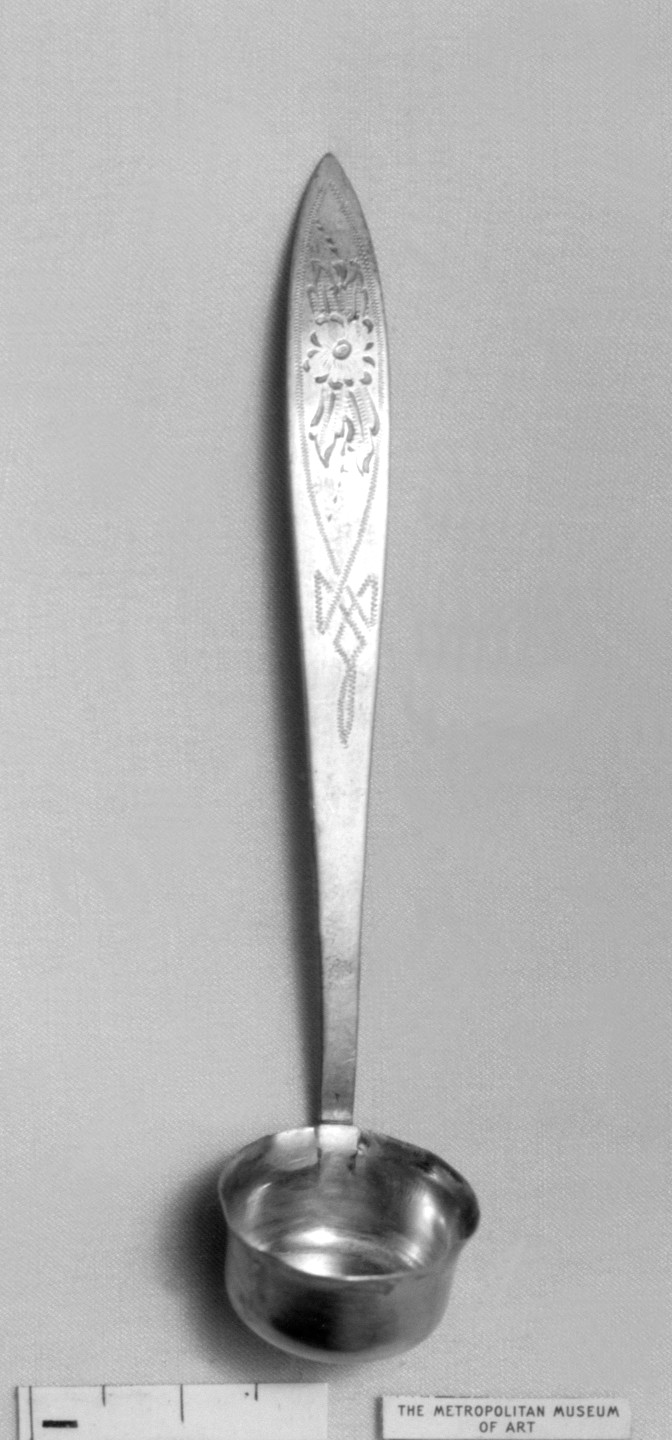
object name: mustard spoon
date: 1801-1900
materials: gilt, silver